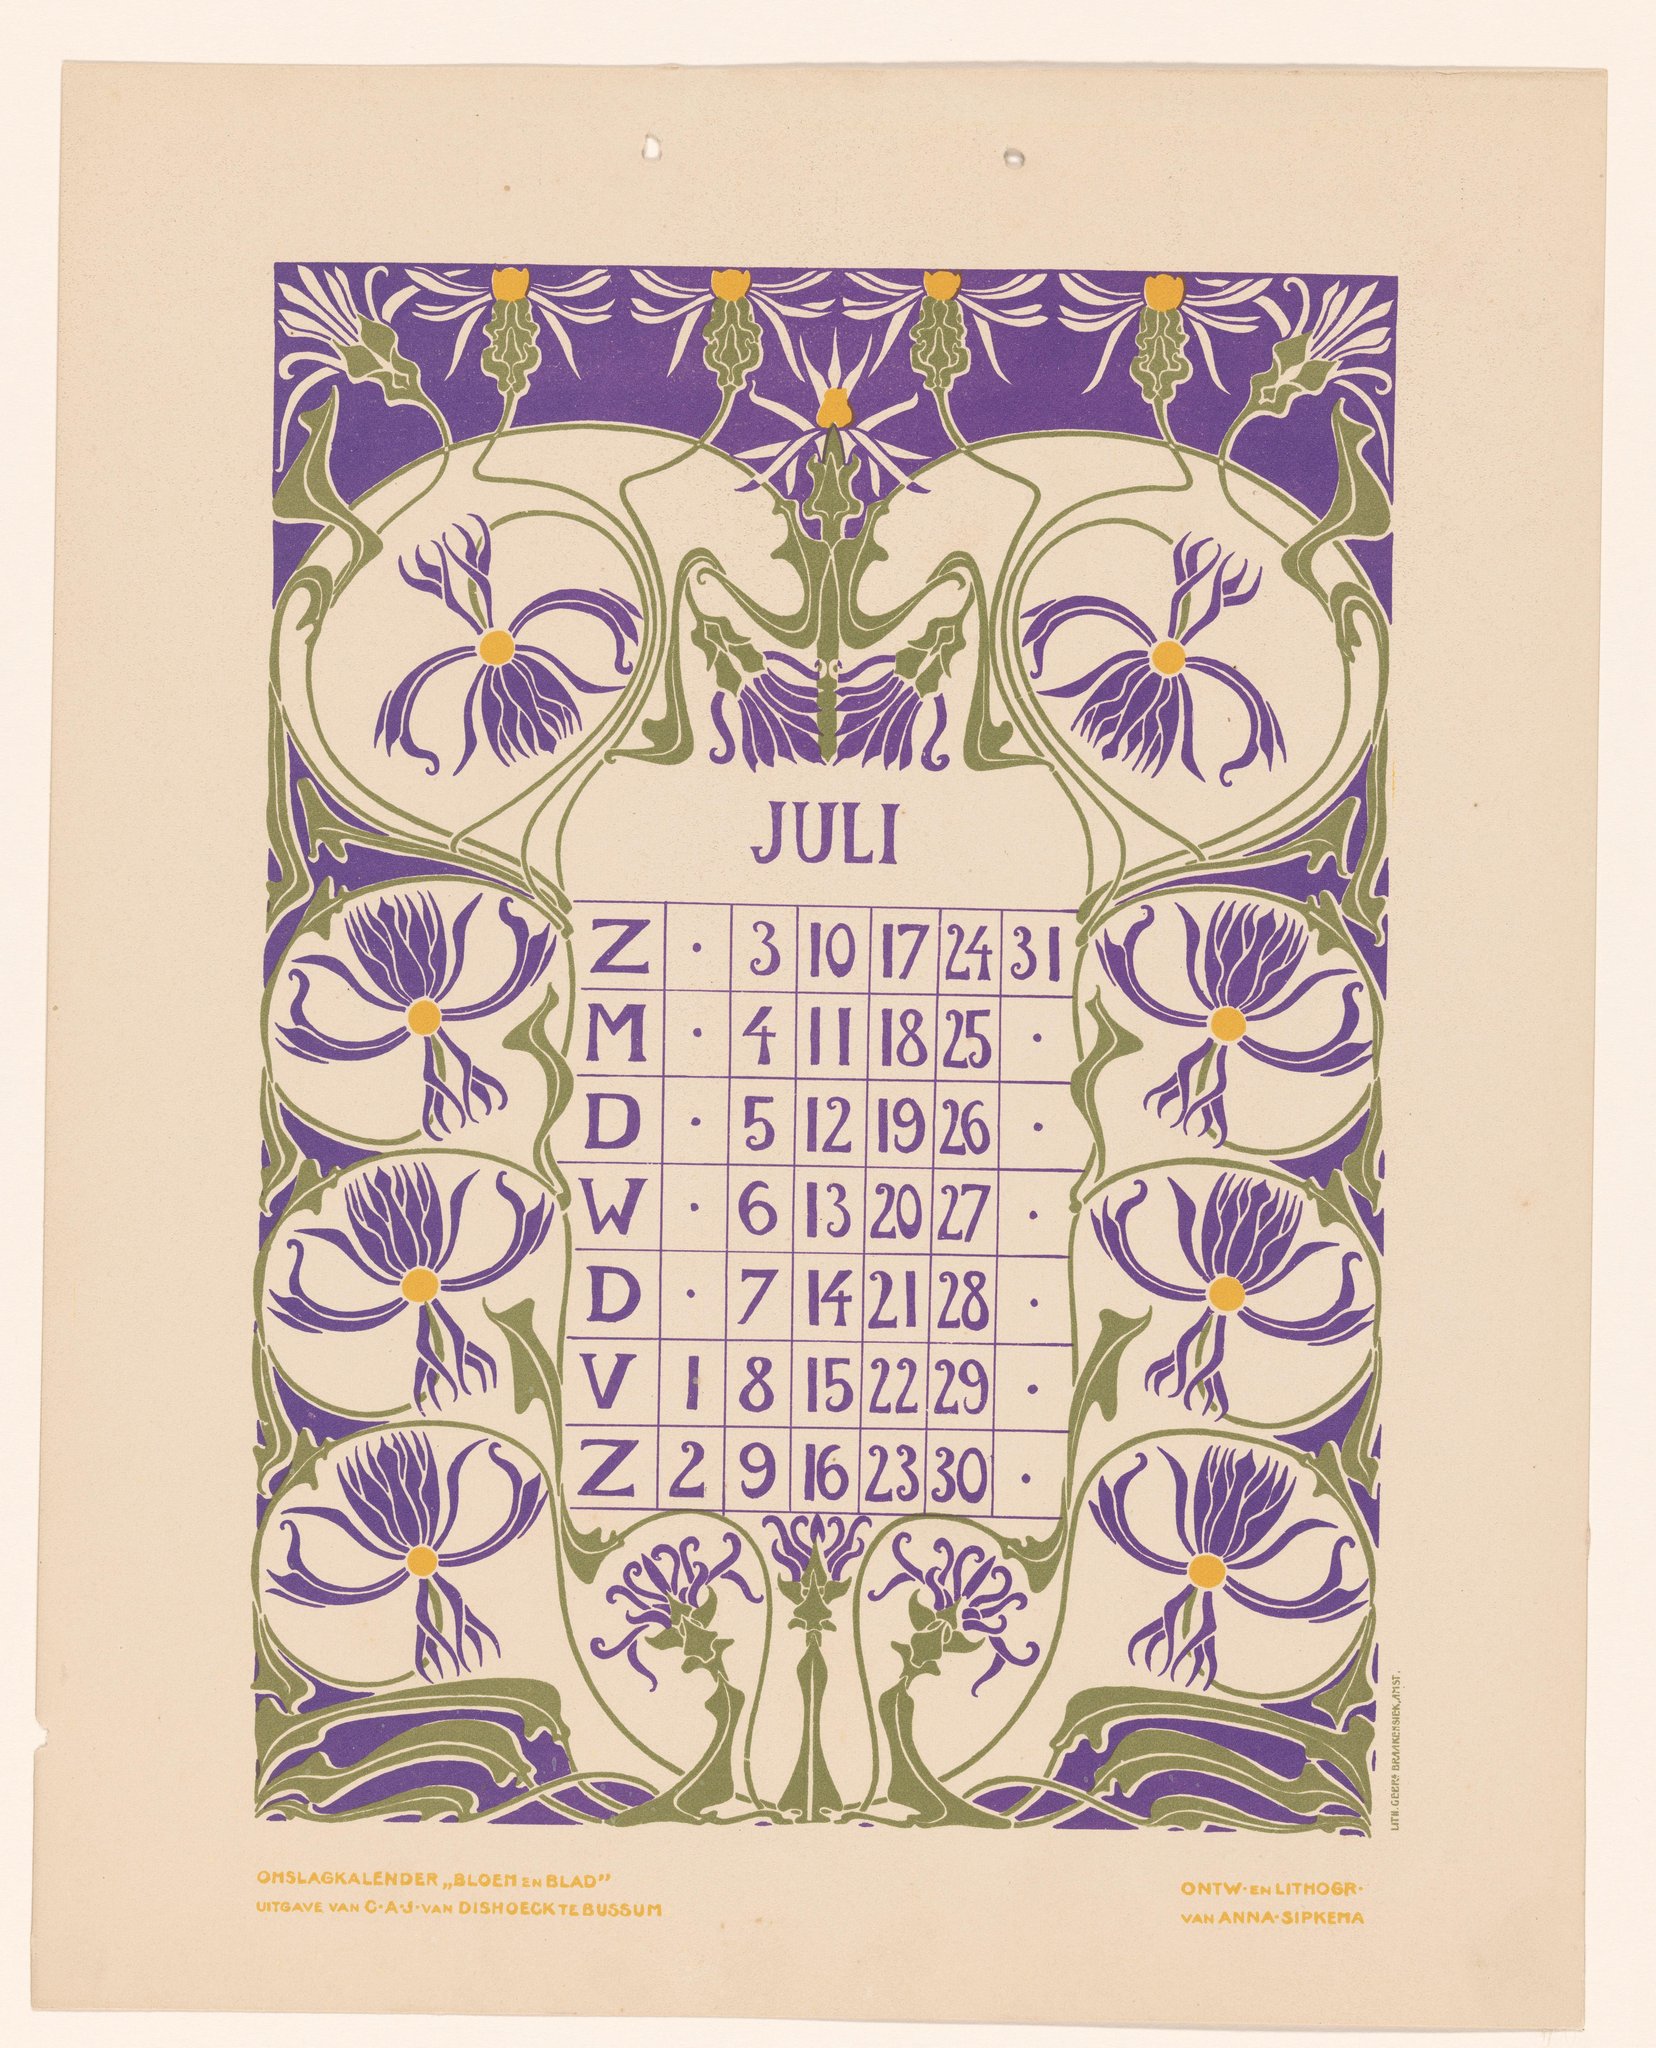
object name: print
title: Omslagkalender "Bloem en blad"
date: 1904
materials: paper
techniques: lithograph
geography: bussum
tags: flowers, july ~ other concepts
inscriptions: collector's mark: Lugt 2228